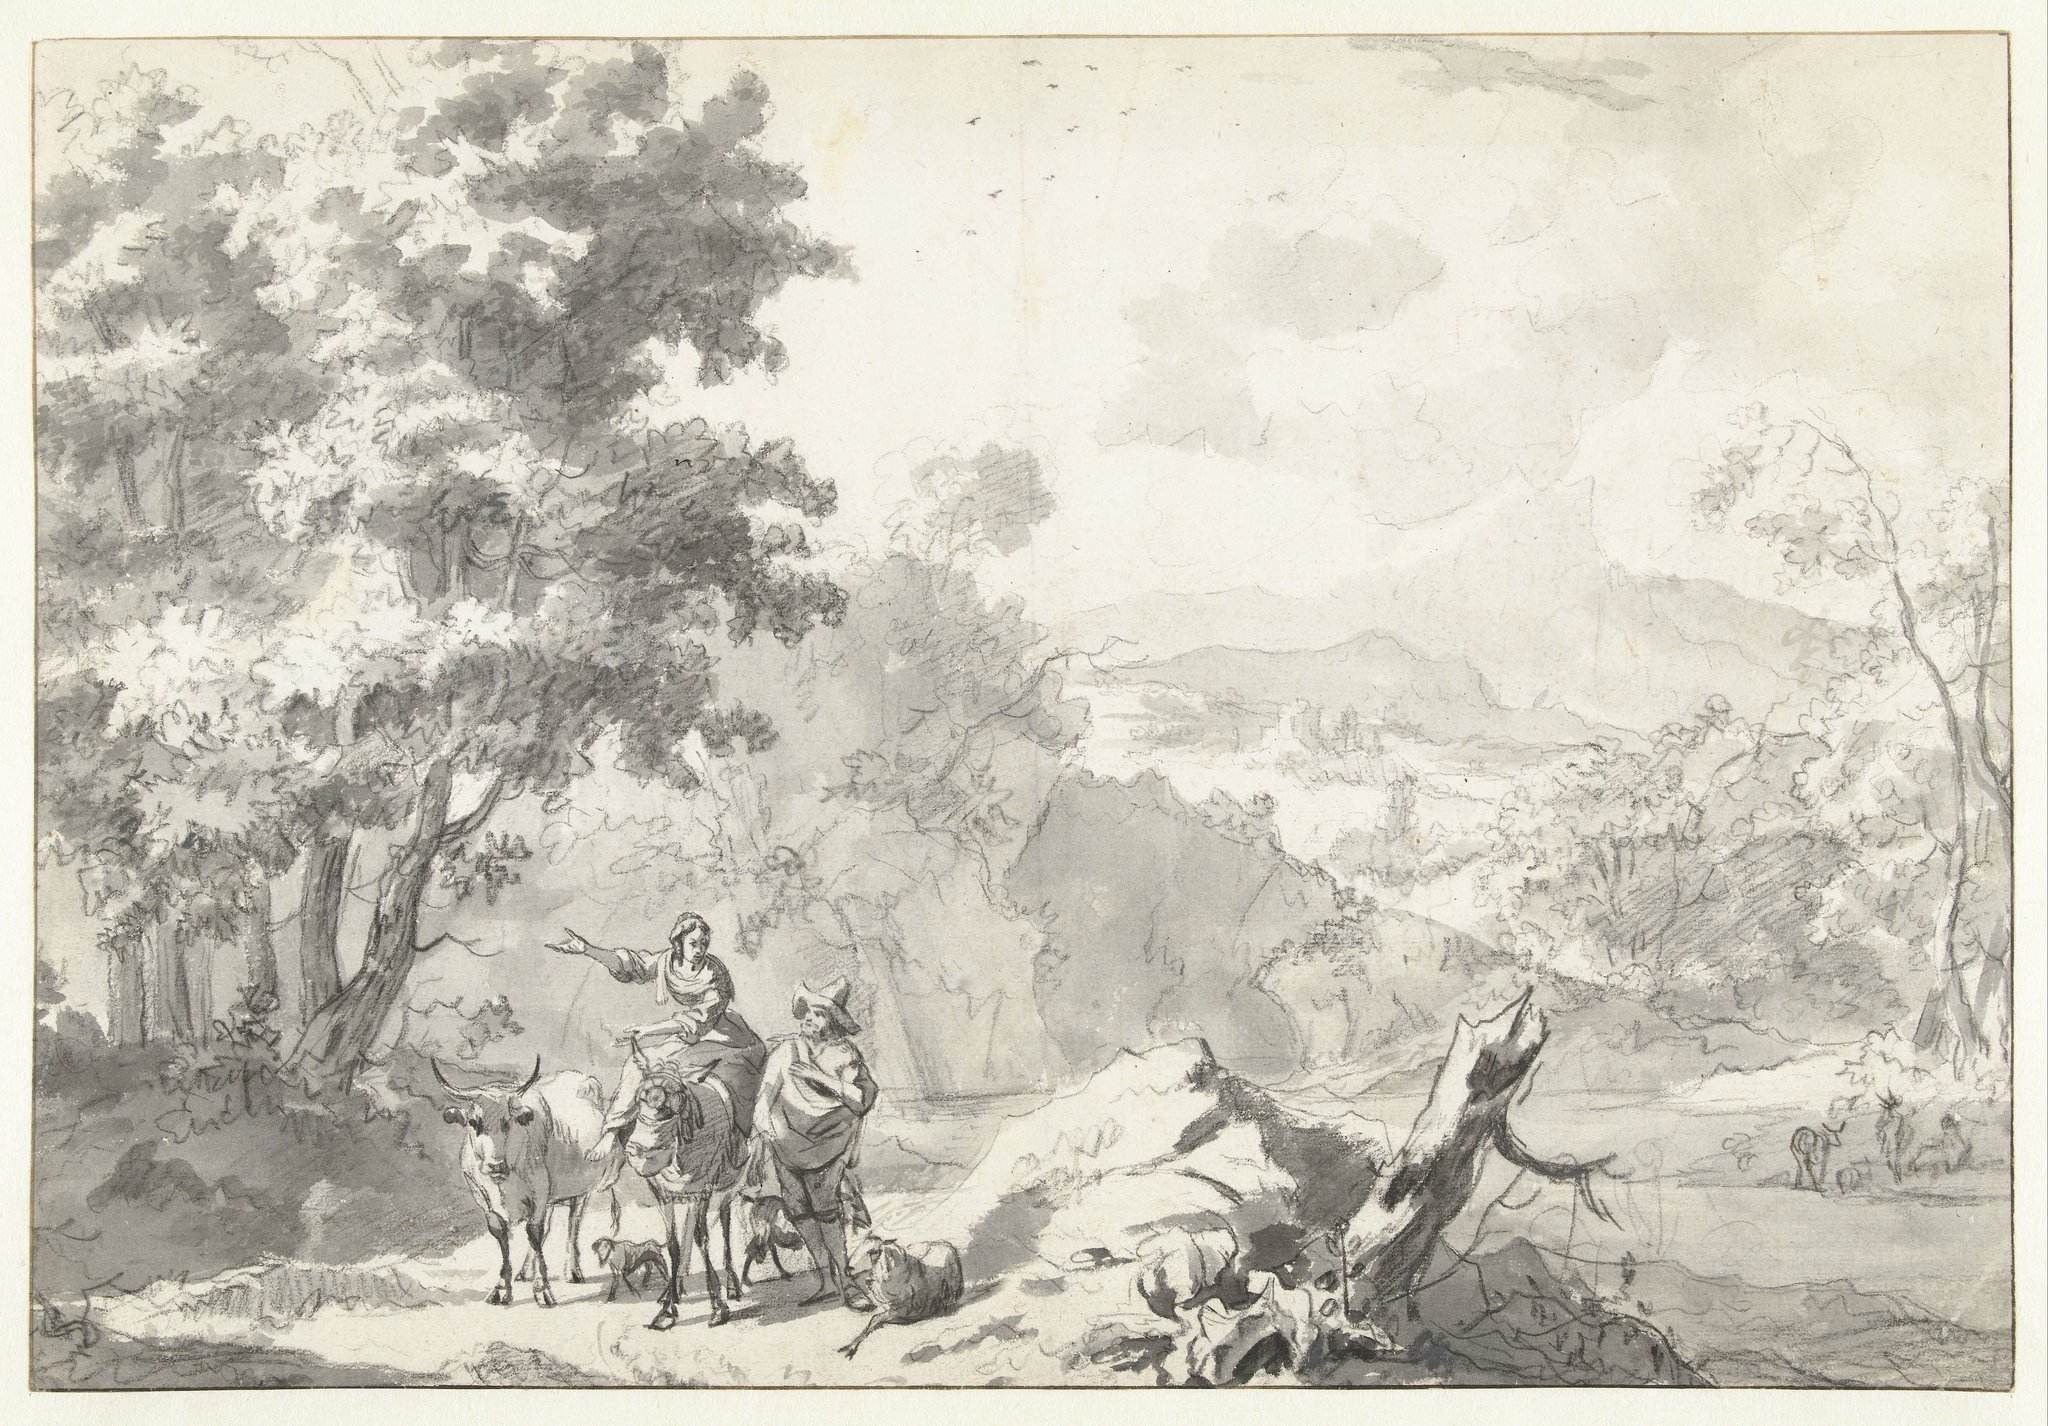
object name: drawing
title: Italianate Landscape with Herders and their Flock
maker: abraham jansz begeyn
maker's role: draughtsman, print maker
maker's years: 1637-1697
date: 1660-1685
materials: chalk, paper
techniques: brush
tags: riding a horse, ass, or mule; rider, horseman, herding, herdsman, herdswoman, shepherd, shepherdess, cowherd, etc., (high) hill (+ landscape with figures, staffage)